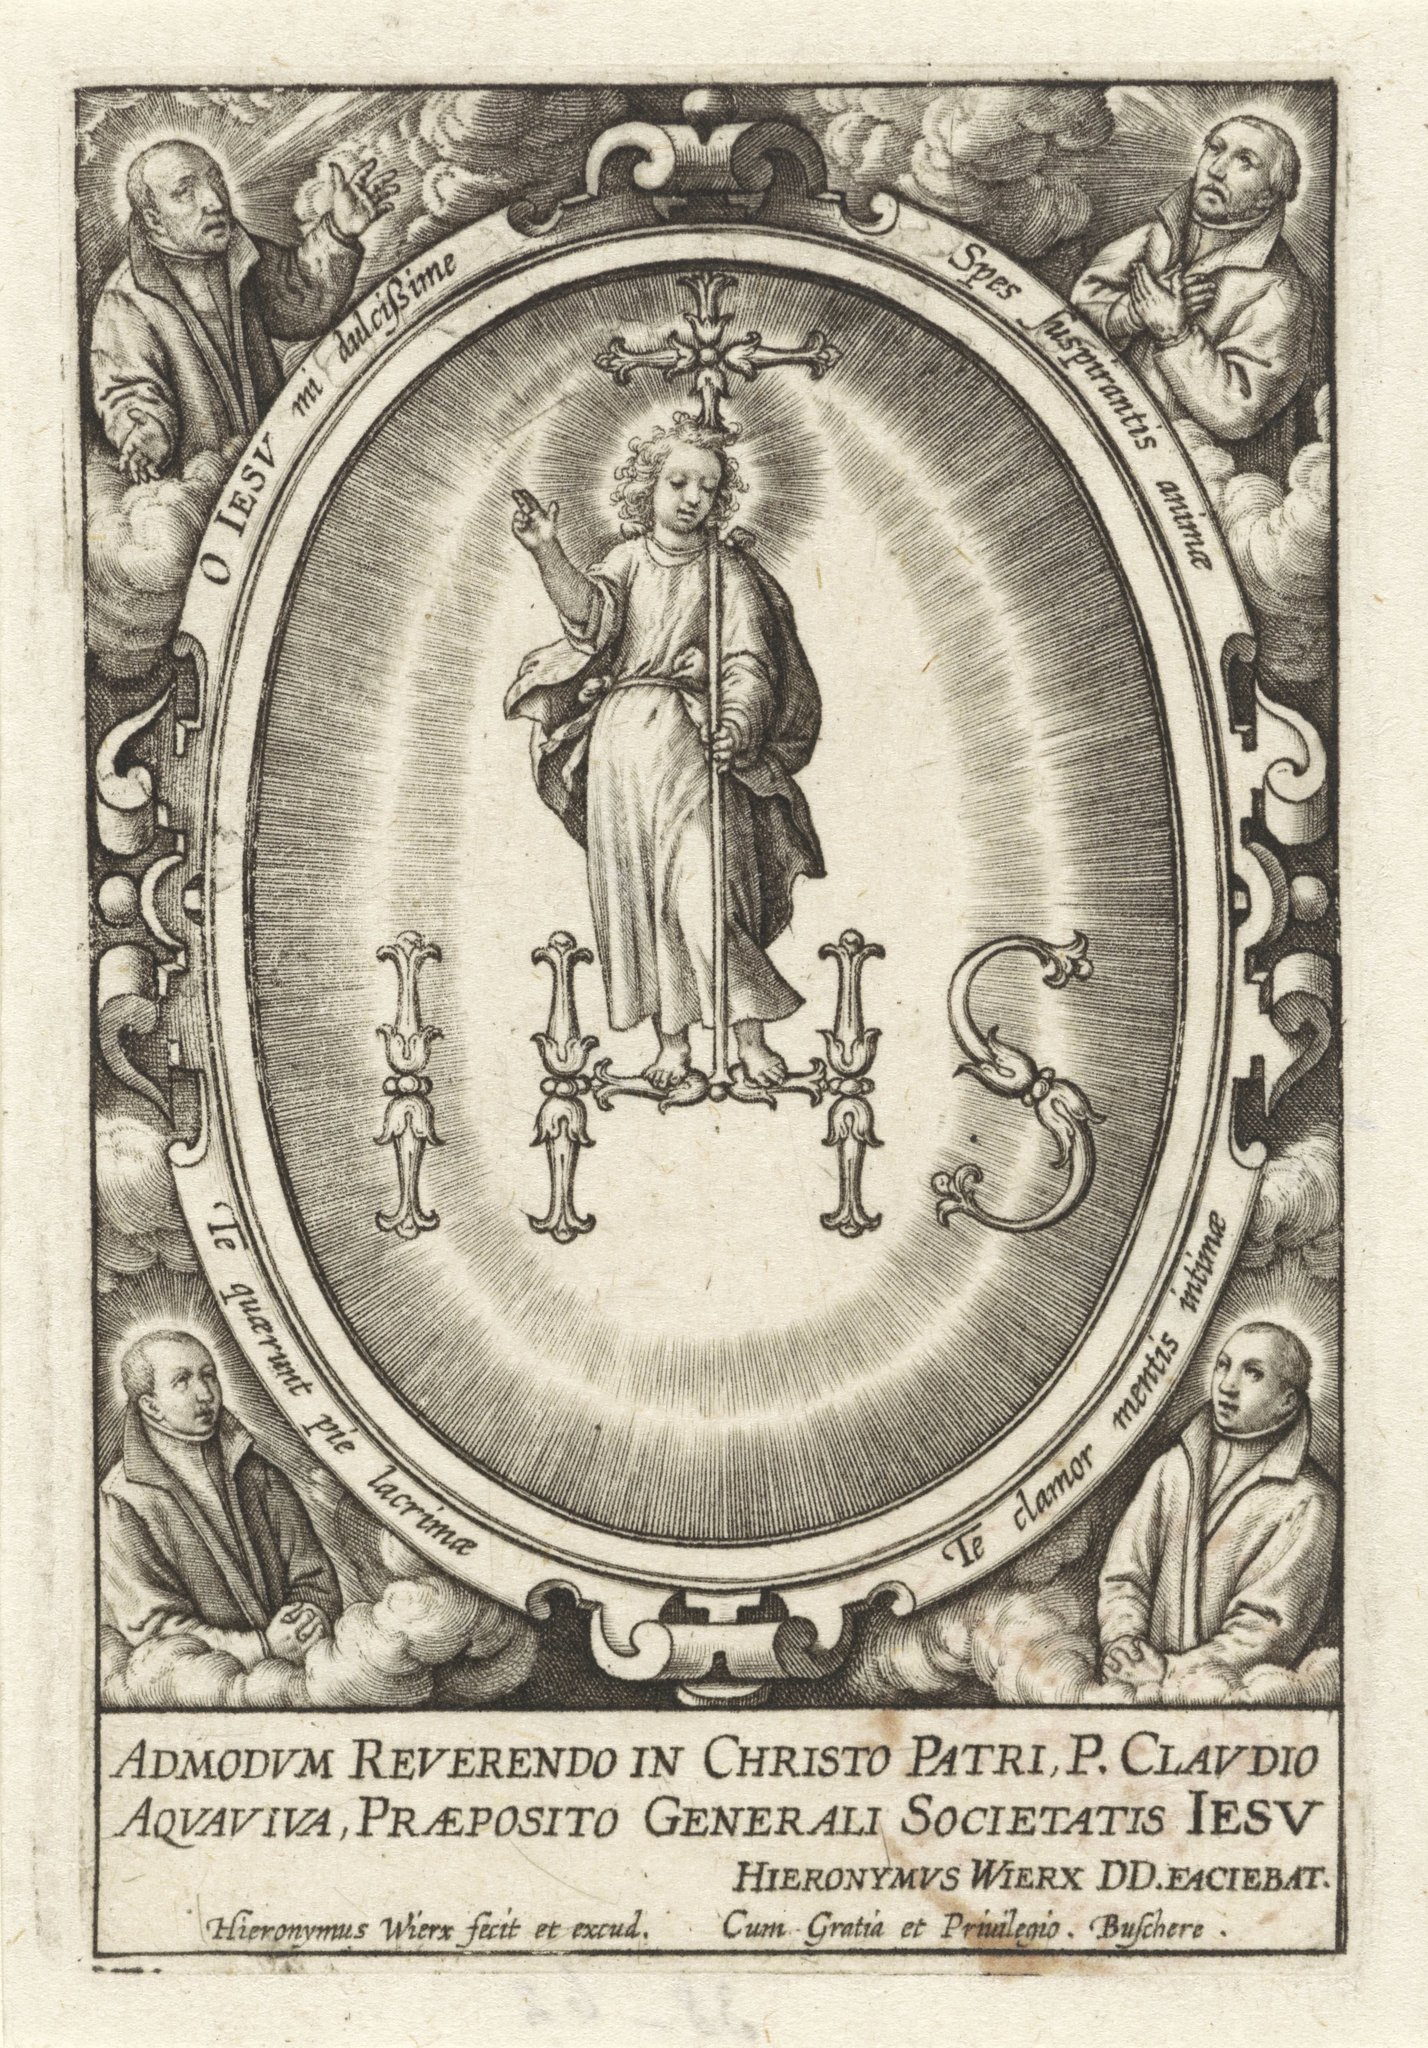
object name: print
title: Christuskind staand op monogram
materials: paper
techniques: engraving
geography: antwerp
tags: clergyman, missionary, rome, the jesuit friar aloysius gonzaga; possible attributes: crucifix, discipline, lily, skull, adoration of the name of jesus, the founder of the jesuit order, ignatius of loyola; possible attributes: book (with 'ad majorem dei gloriam'), demon, dragon under feet, flames, flaming heart, globe, ihs monogram, skull (with crown), tears in eyes, torch, the jesuit missionary francis xavier; possible attributes: cross, crucifix, flaming heart, indian, lily, torch, male saints (with name)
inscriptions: number: ‘38 - 62’, collector's mark: Lugt 240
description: Het Christuskind maakt een zegenend gebaar en staat op het monogram IHS. De voorstelling is gevat in een ovale omlijsting met een randschrift in het Latijn. In de hoeken de busteportretten van vier Jezuïten: Ignatius van Loyola (linksboven), Francis Xavier (rechtsboven), Aloysius Gonzaga (linksonder) en Stanislaus Kostka (rechtsonder). In de marge een tweeregelig onderschrift met een opdracht in het Latijn.